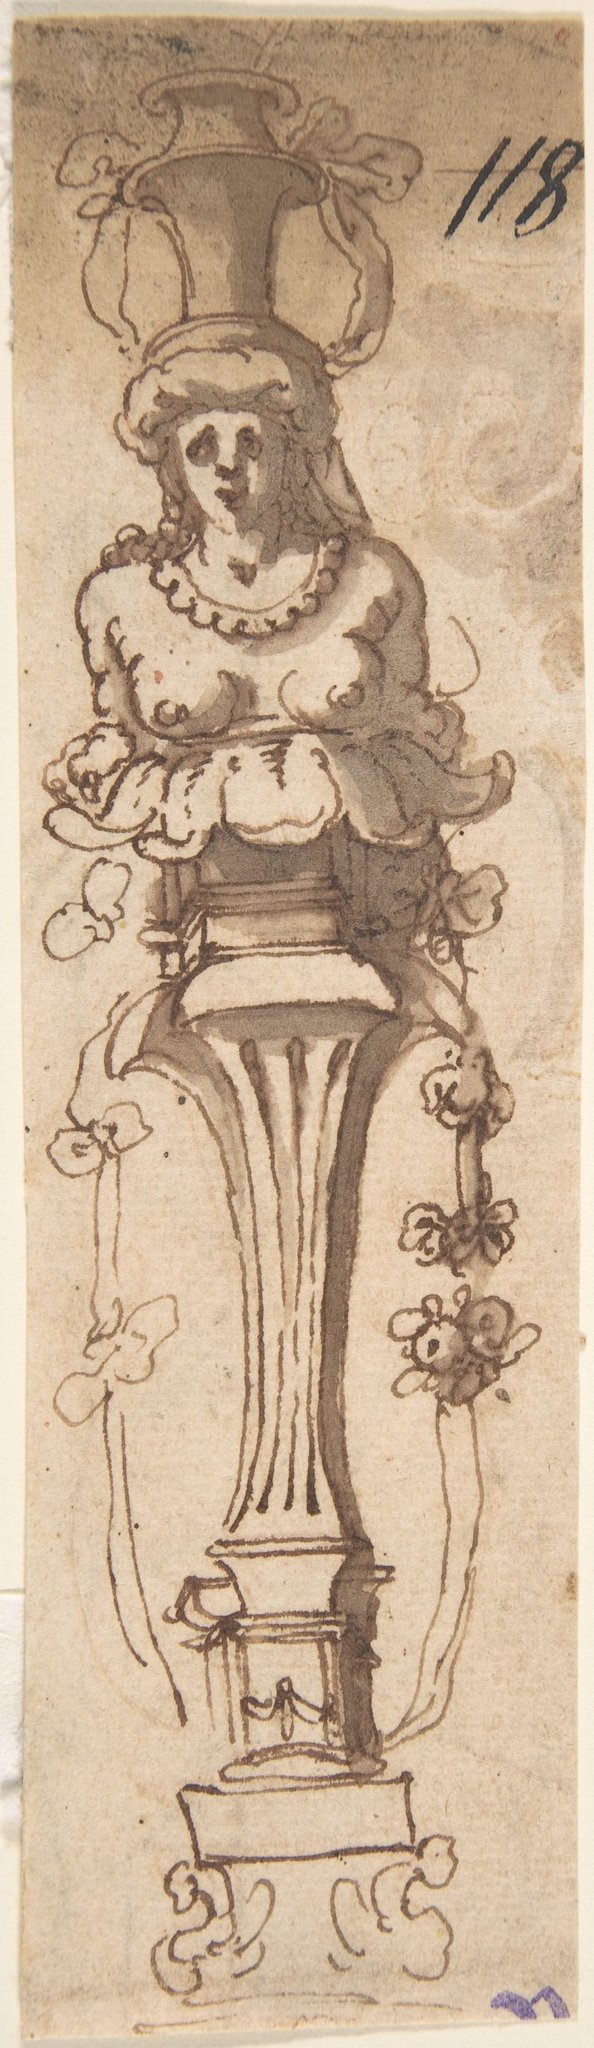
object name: drawing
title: Design for A Female Term Carrying a Vase (recto); Sketch of Draped Male (verso)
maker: anonymous, italian, 17th century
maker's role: artist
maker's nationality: italian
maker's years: 1600-1700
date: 1601-1700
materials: chalk, ink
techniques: brush, pen, wash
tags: female nudes,vases